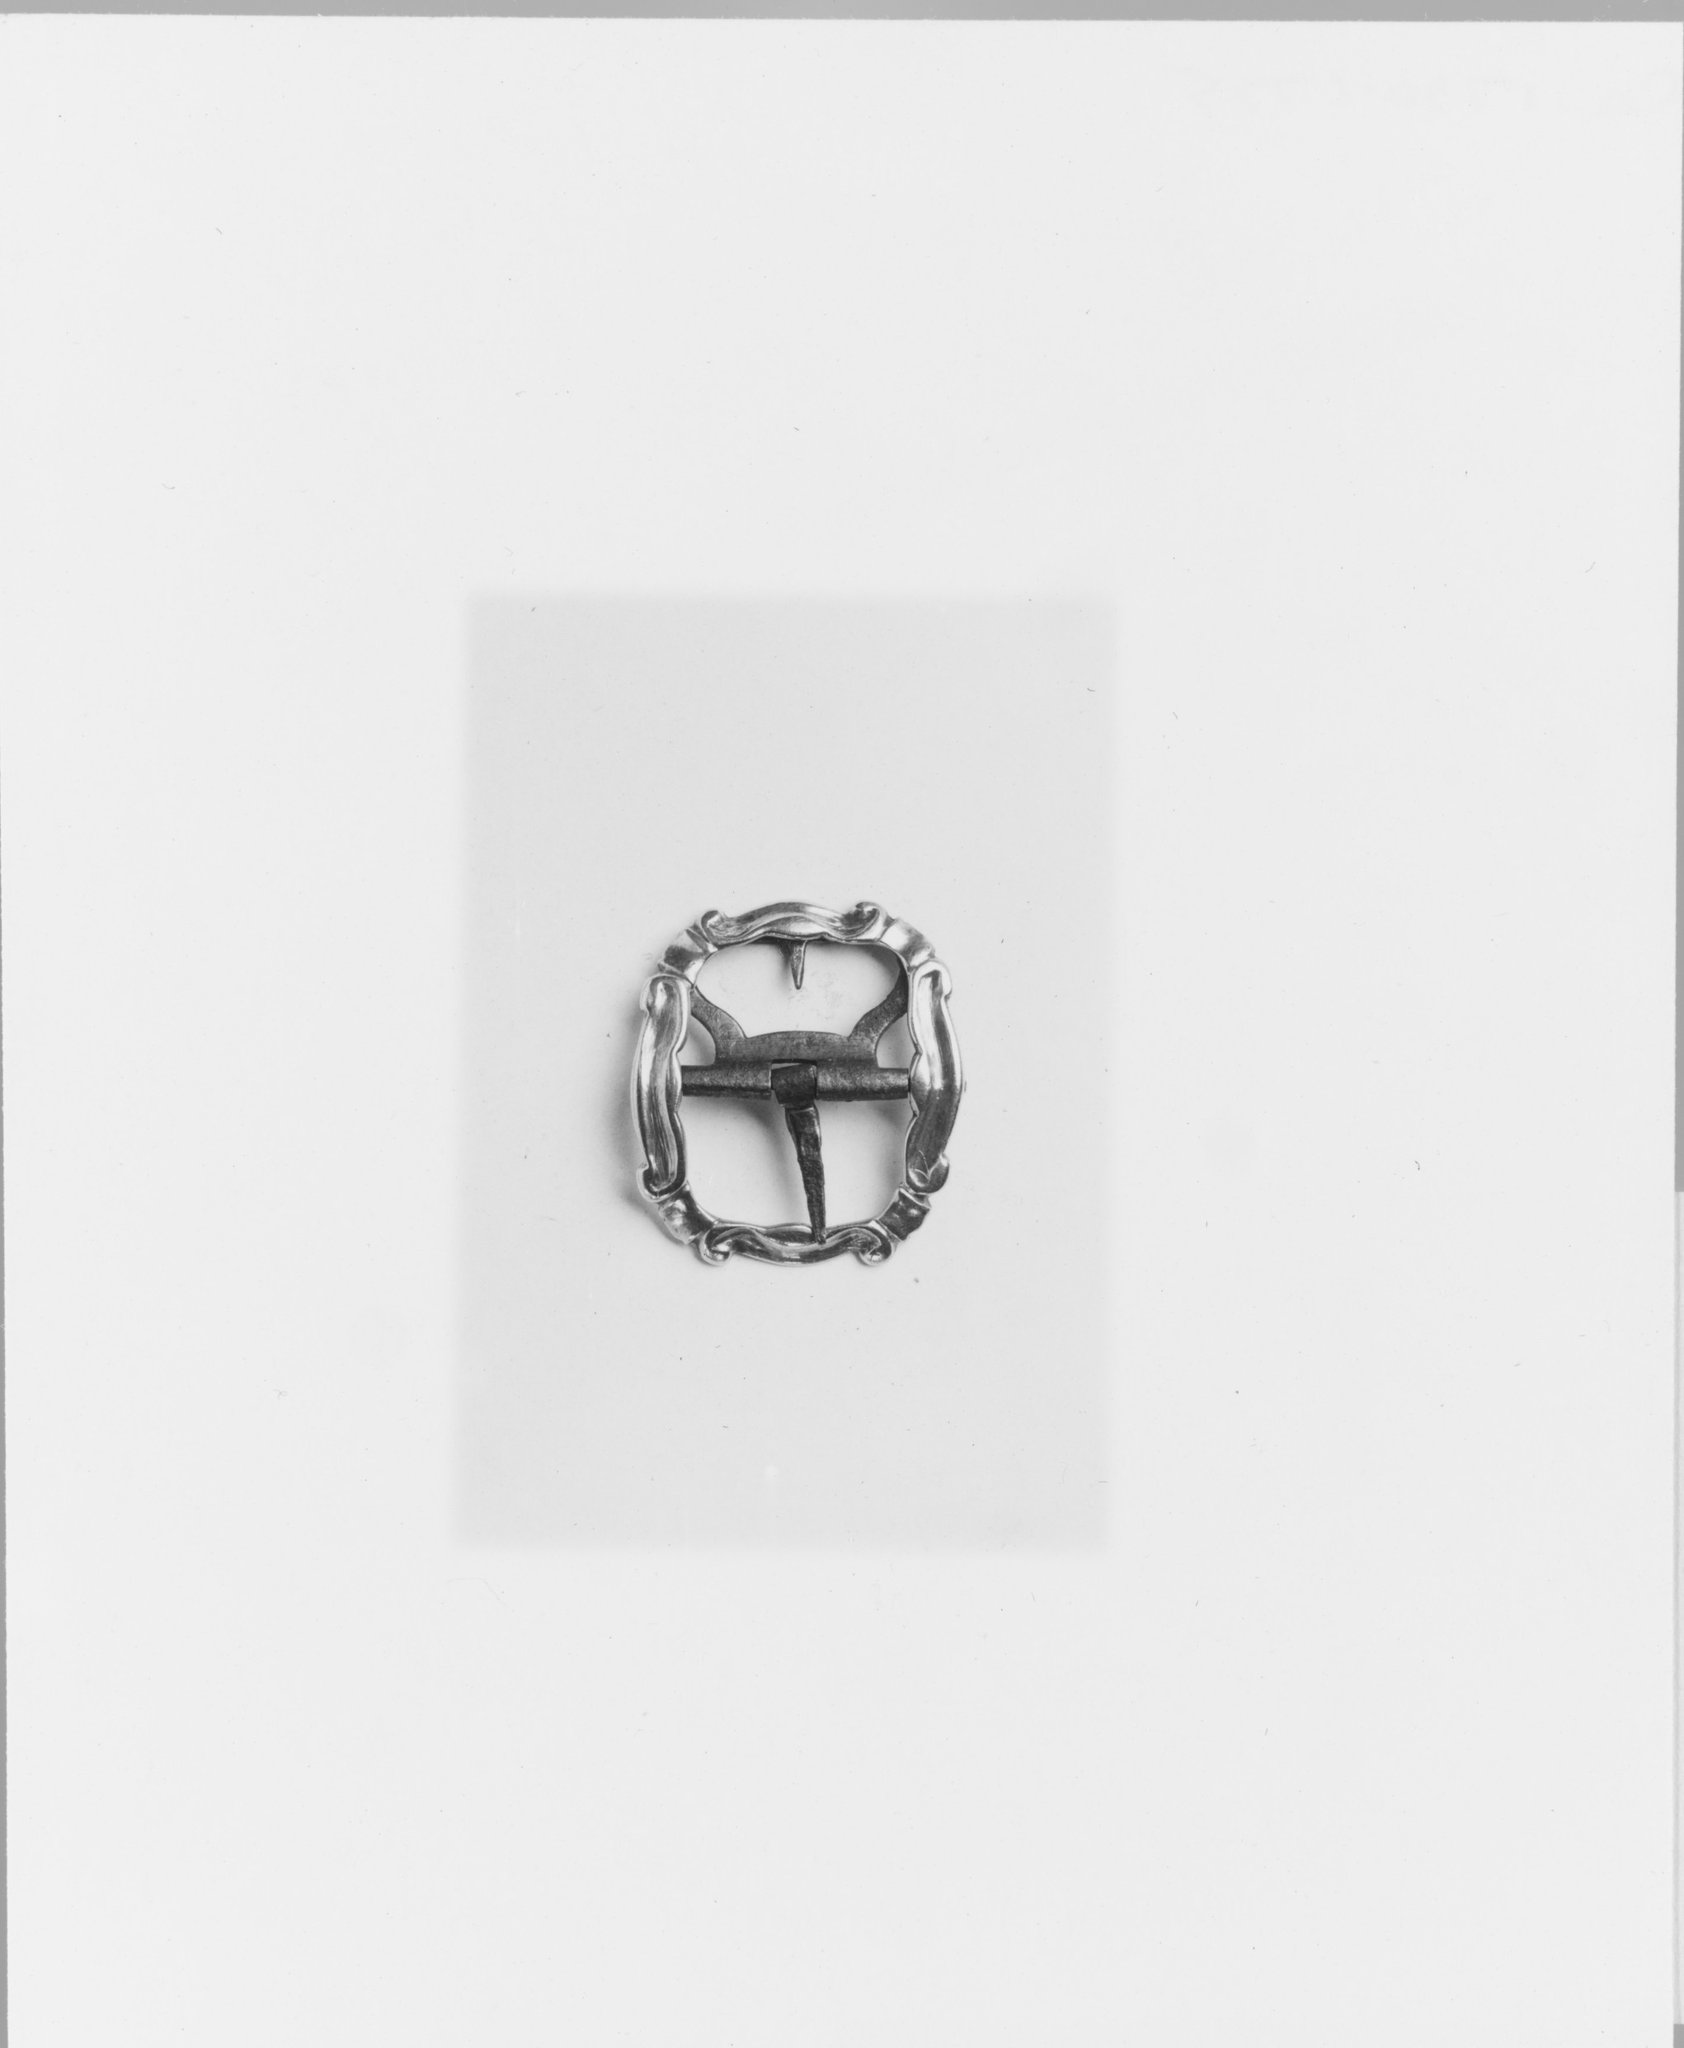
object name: buckle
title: Knee Buckle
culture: american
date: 1730-1775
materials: silver